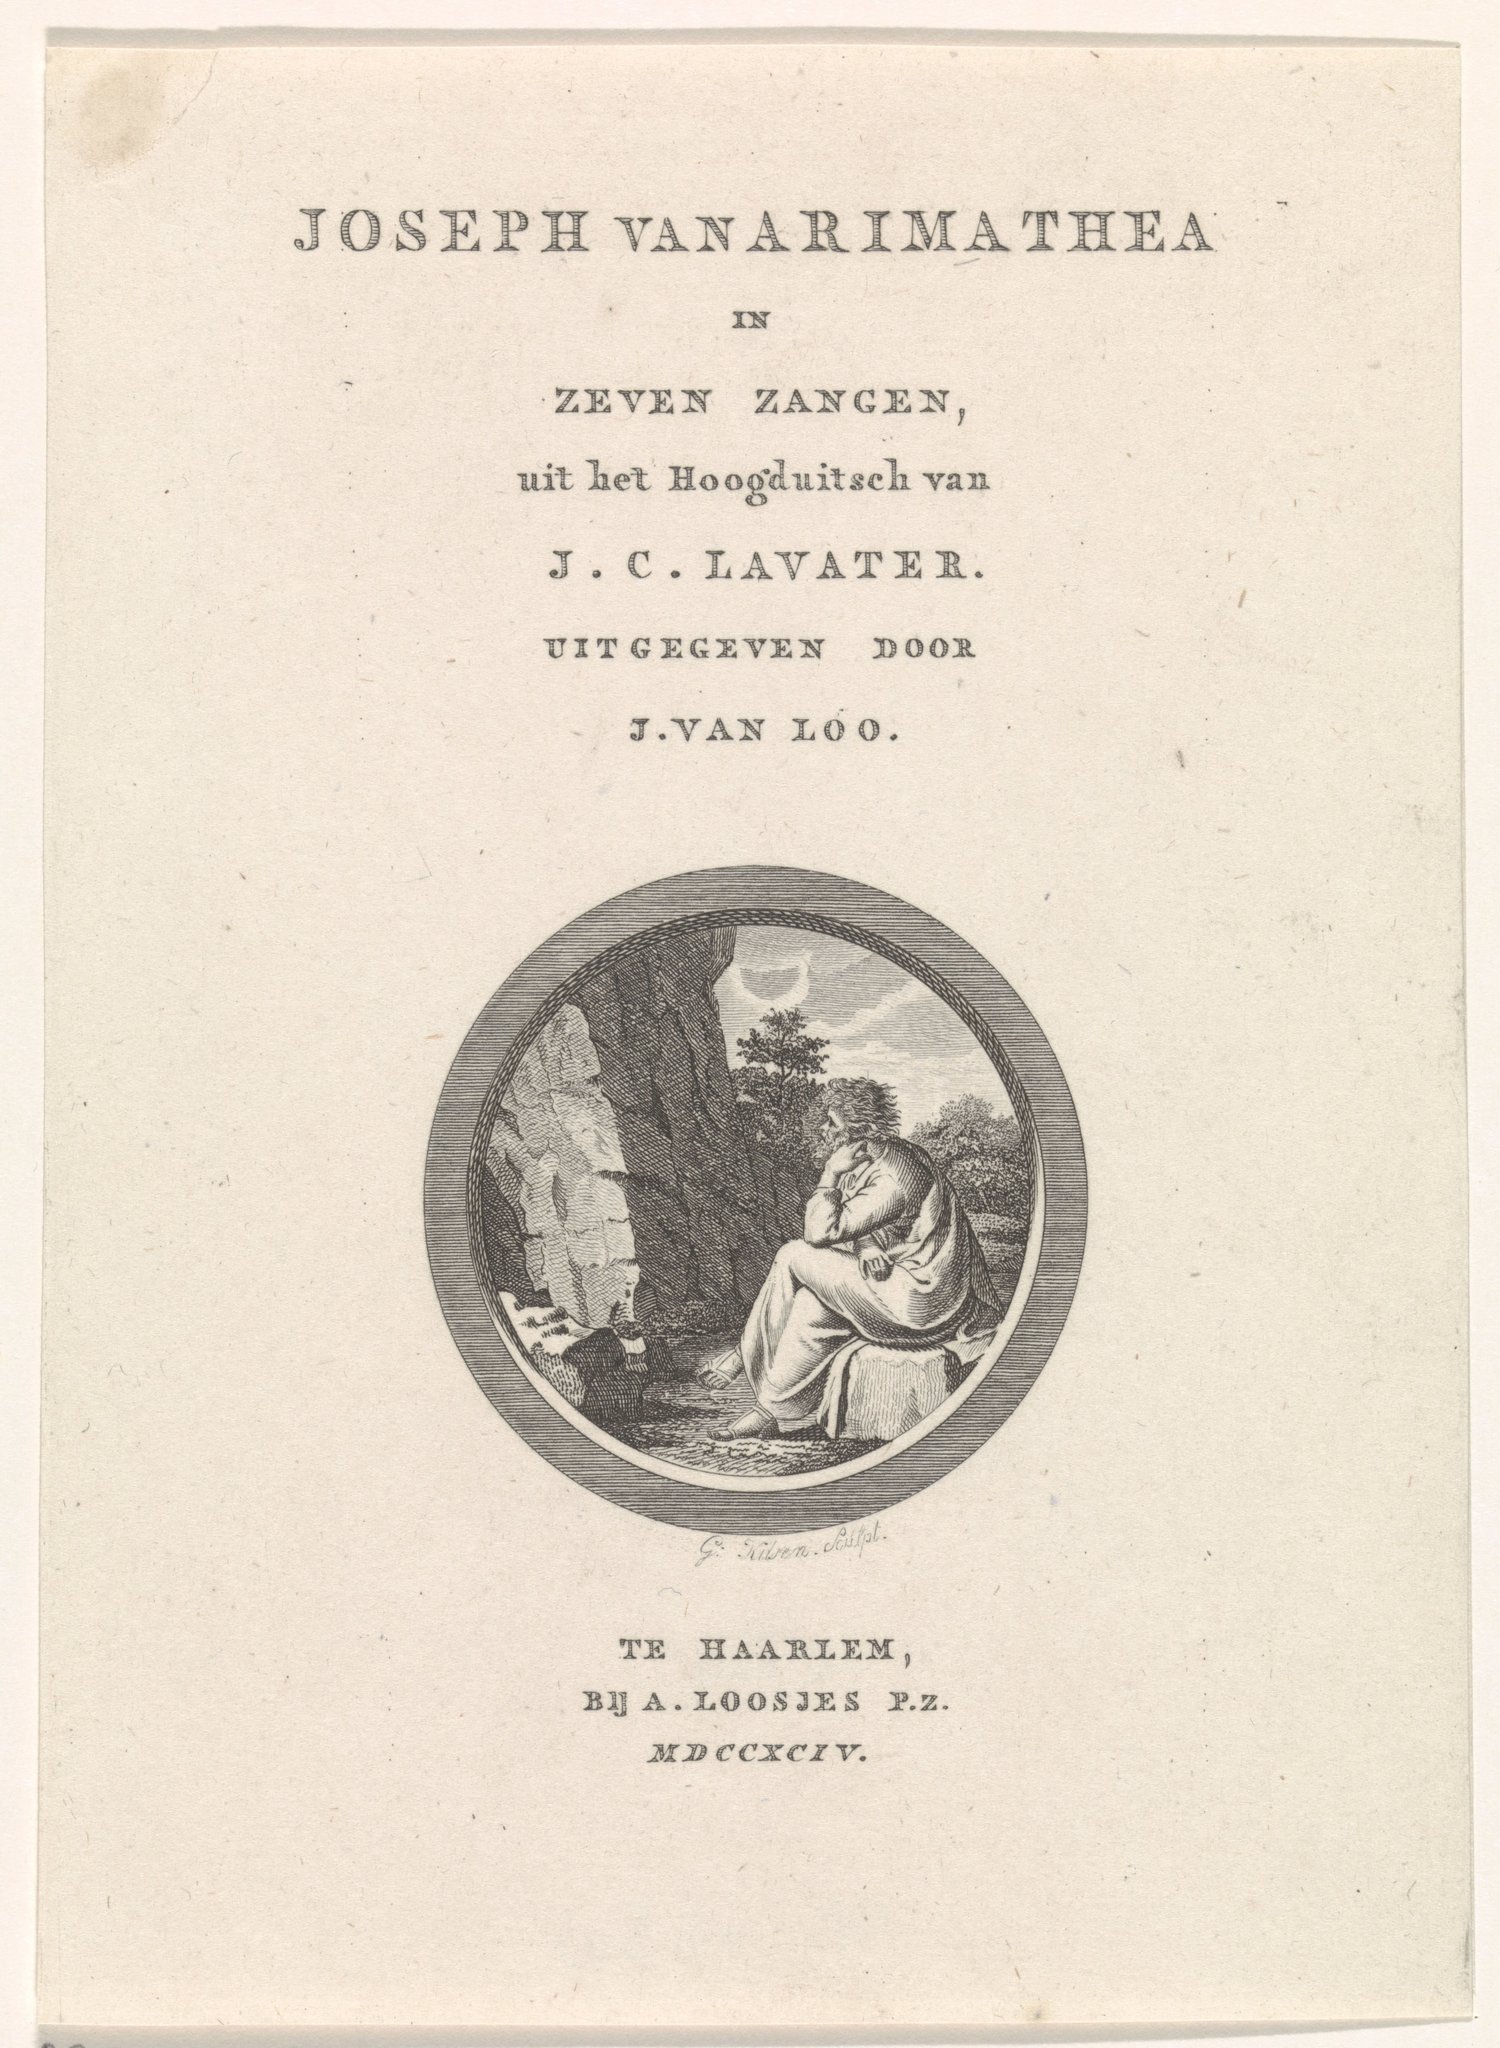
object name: print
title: Titelpagina van een bundel met zeven liederen over Joseph van Arimathea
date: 1796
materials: paper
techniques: etching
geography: rotterdam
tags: male persons from the new testament (with name) (not in biblical context)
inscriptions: collector's mark: Lugt 2228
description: Titelpagina van een bundel met zeven liederen over Joseph van Arimathea, met een afbeelding in een cirkelvormige omlijsting van Joseph van Arimathea voor een grot (mogelijk een graf). Hij is gehuld in een klassiek gewaad.